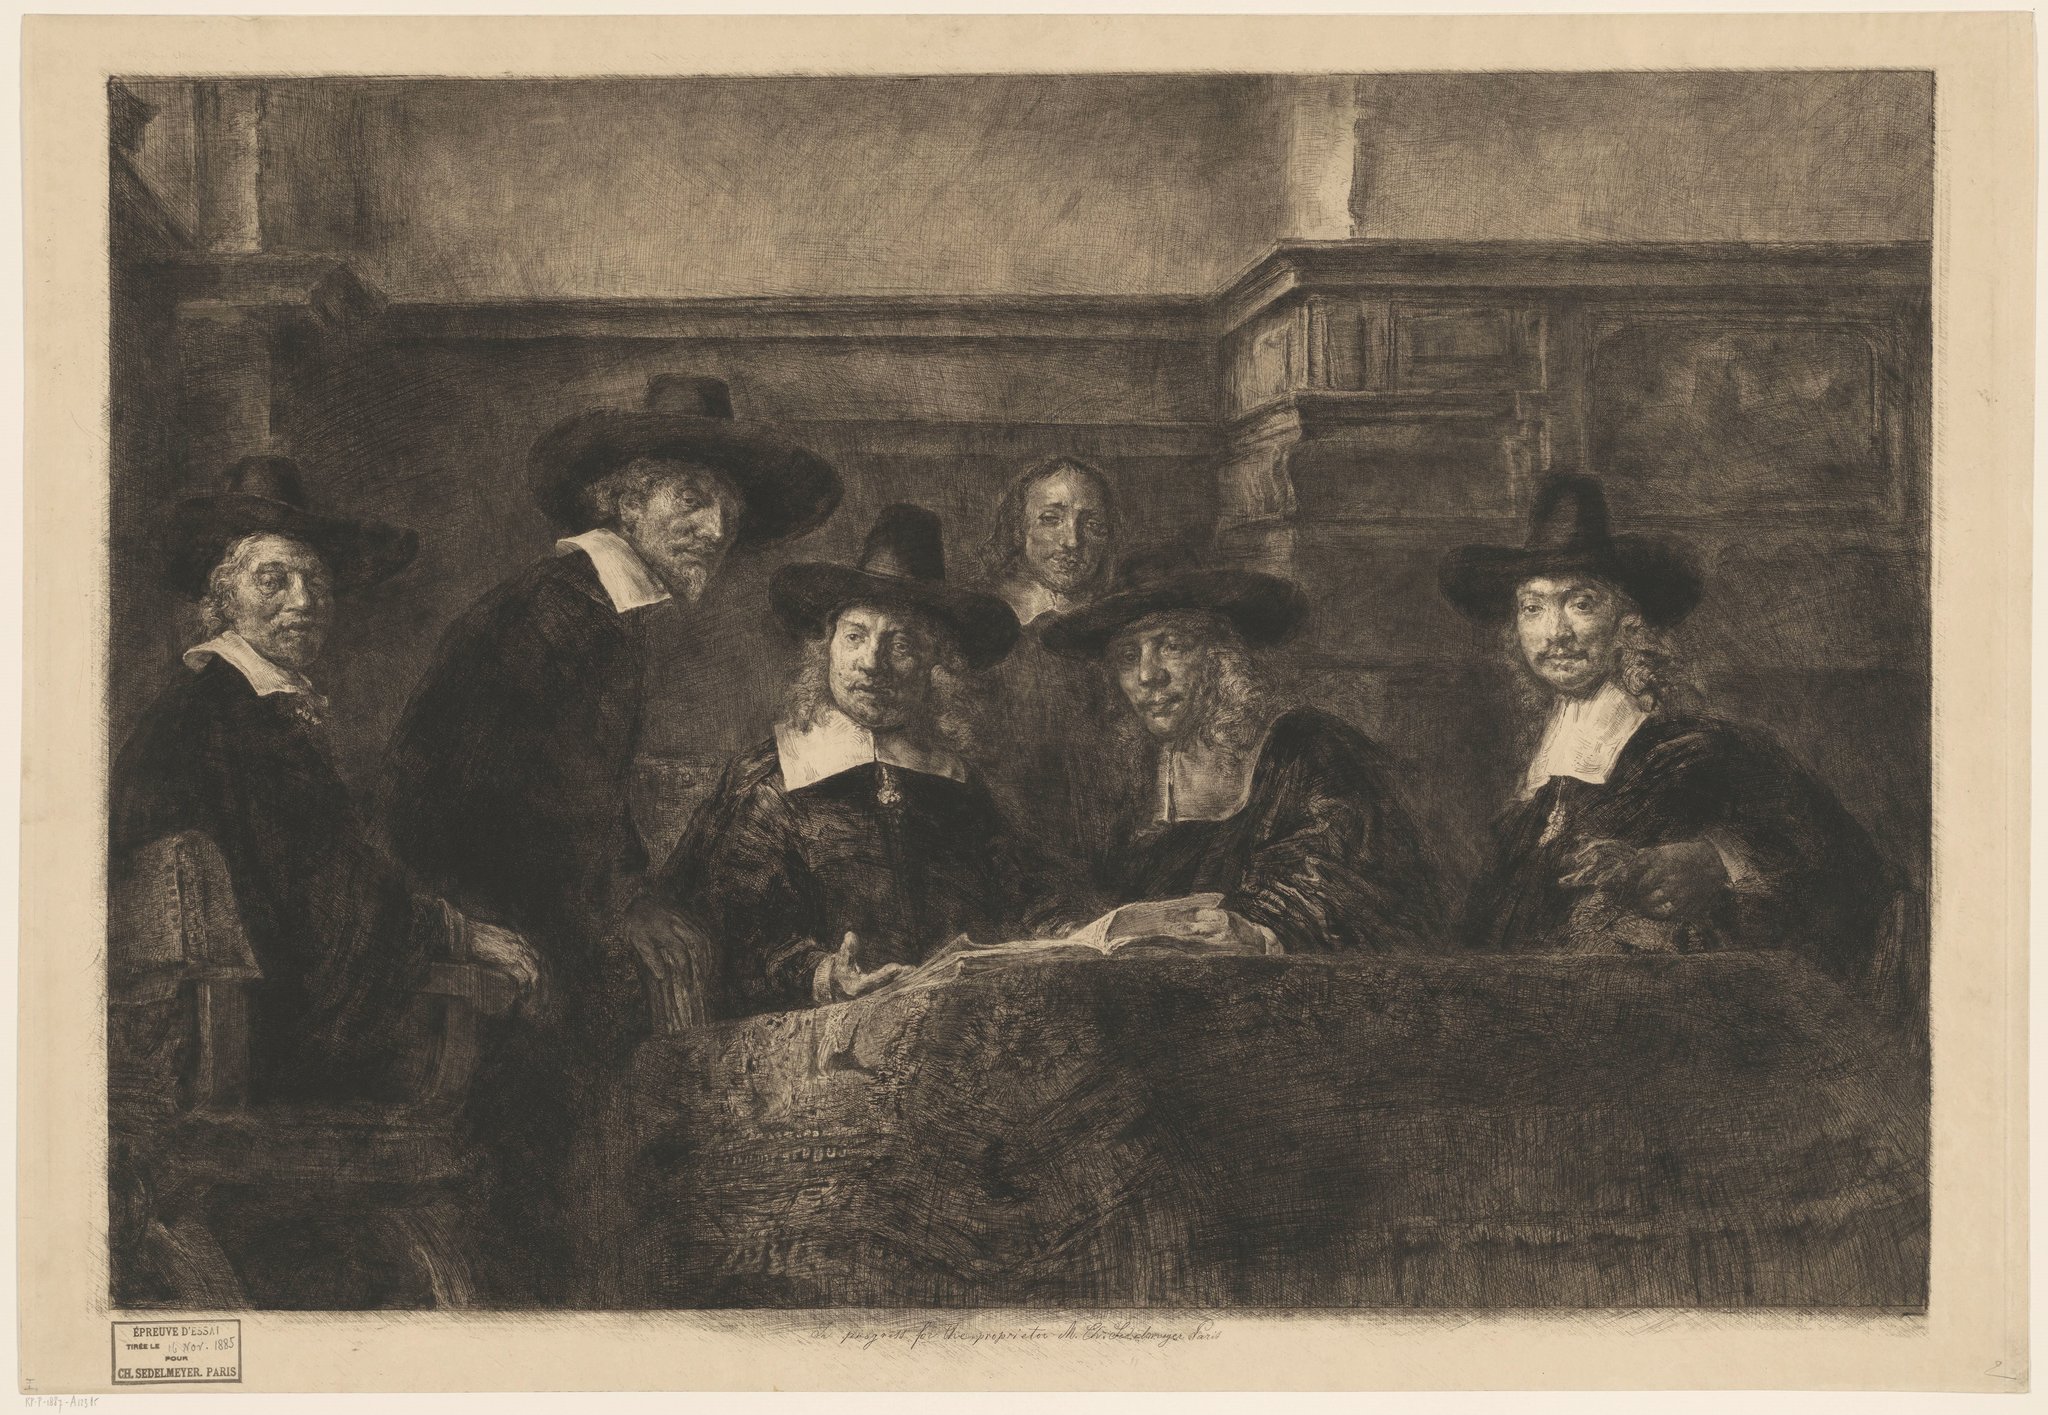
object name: print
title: De waardijns van het Amsterdamse lakenbereidersgilde, bekend als ‘De Staalmeesters’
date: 1885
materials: paper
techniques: etching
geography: paris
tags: hoorn (north holland), utrecht, amsterdam, book - mm - book open, table, officers trusted with control of quality, wool (material ~ textile industry)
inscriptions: stamp: ‘épreuve d'essai/ tirée le 10 Nov. 1885/ pour/ Ch. Sedelmeyer, Paris’, collector's mark: Lugt 2228